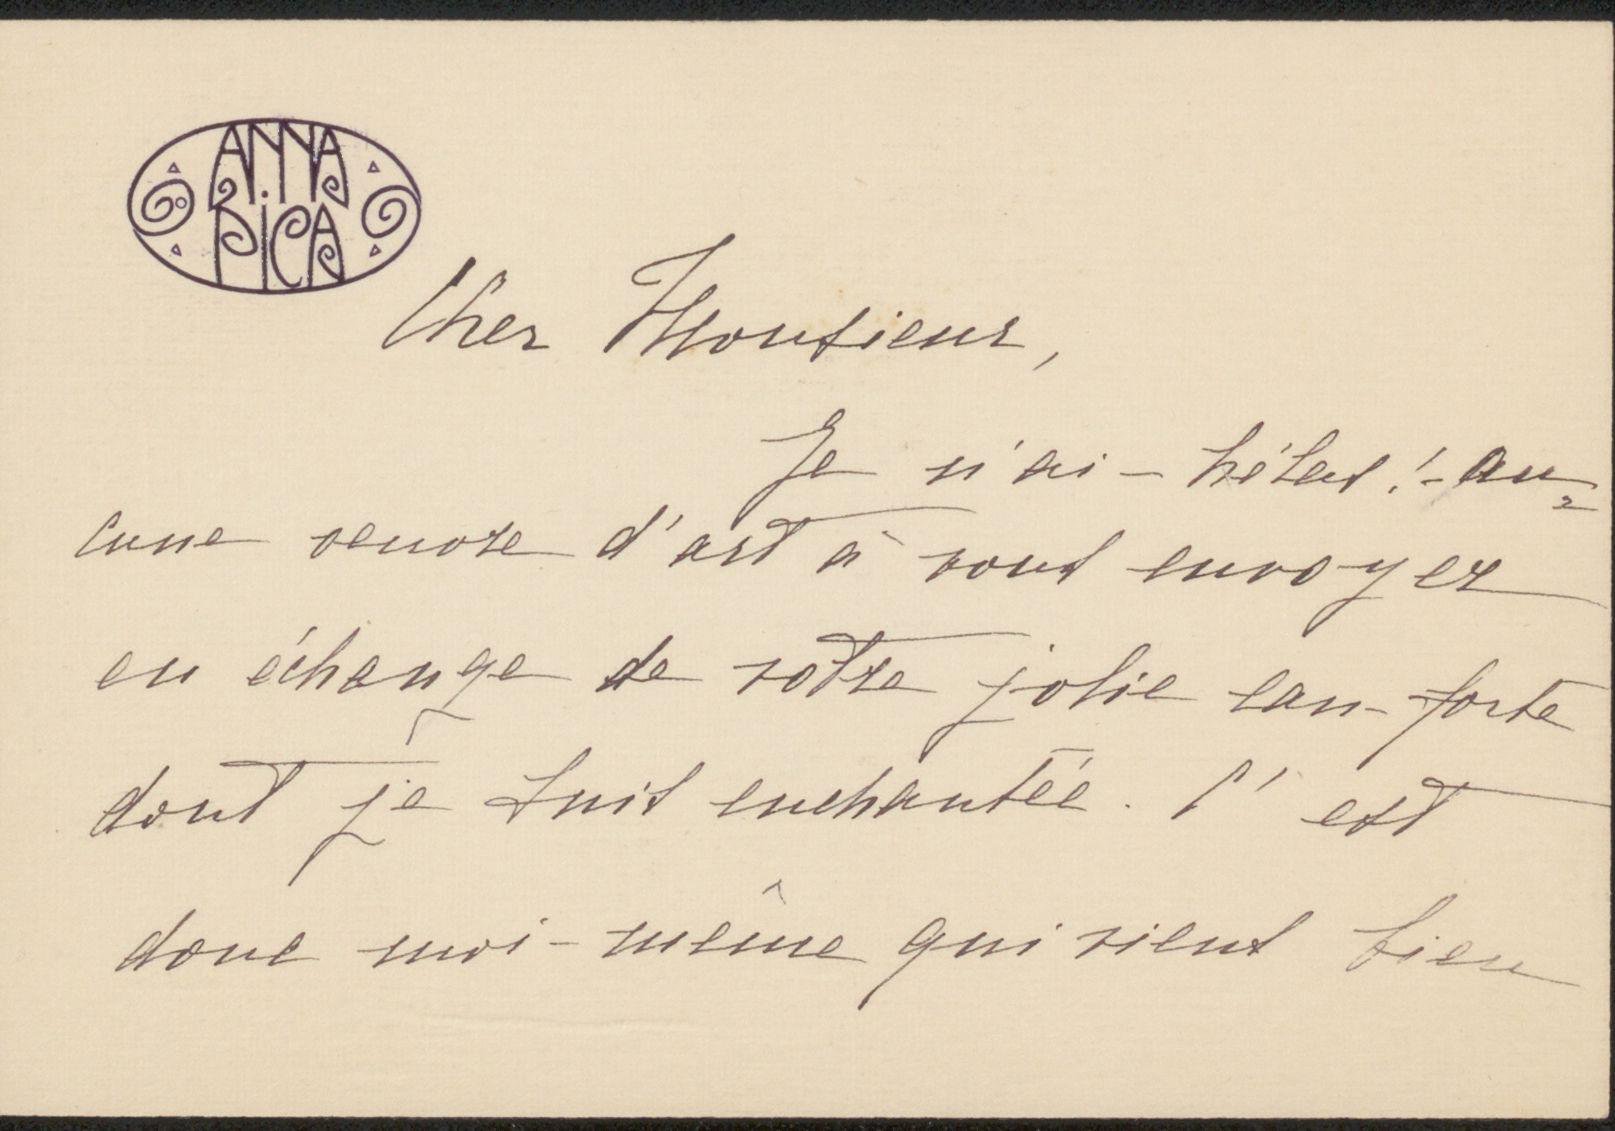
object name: letter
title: Brief aan Philip Zilcken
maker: anna pica-marazzani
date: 1913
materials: cardboard, ink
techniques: pen, writing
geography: venice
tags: painter, draughtsman, philip zilcken, the graphic arts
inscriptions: collector's mark: ‘RPK’, name: ‘ANNA PICA’